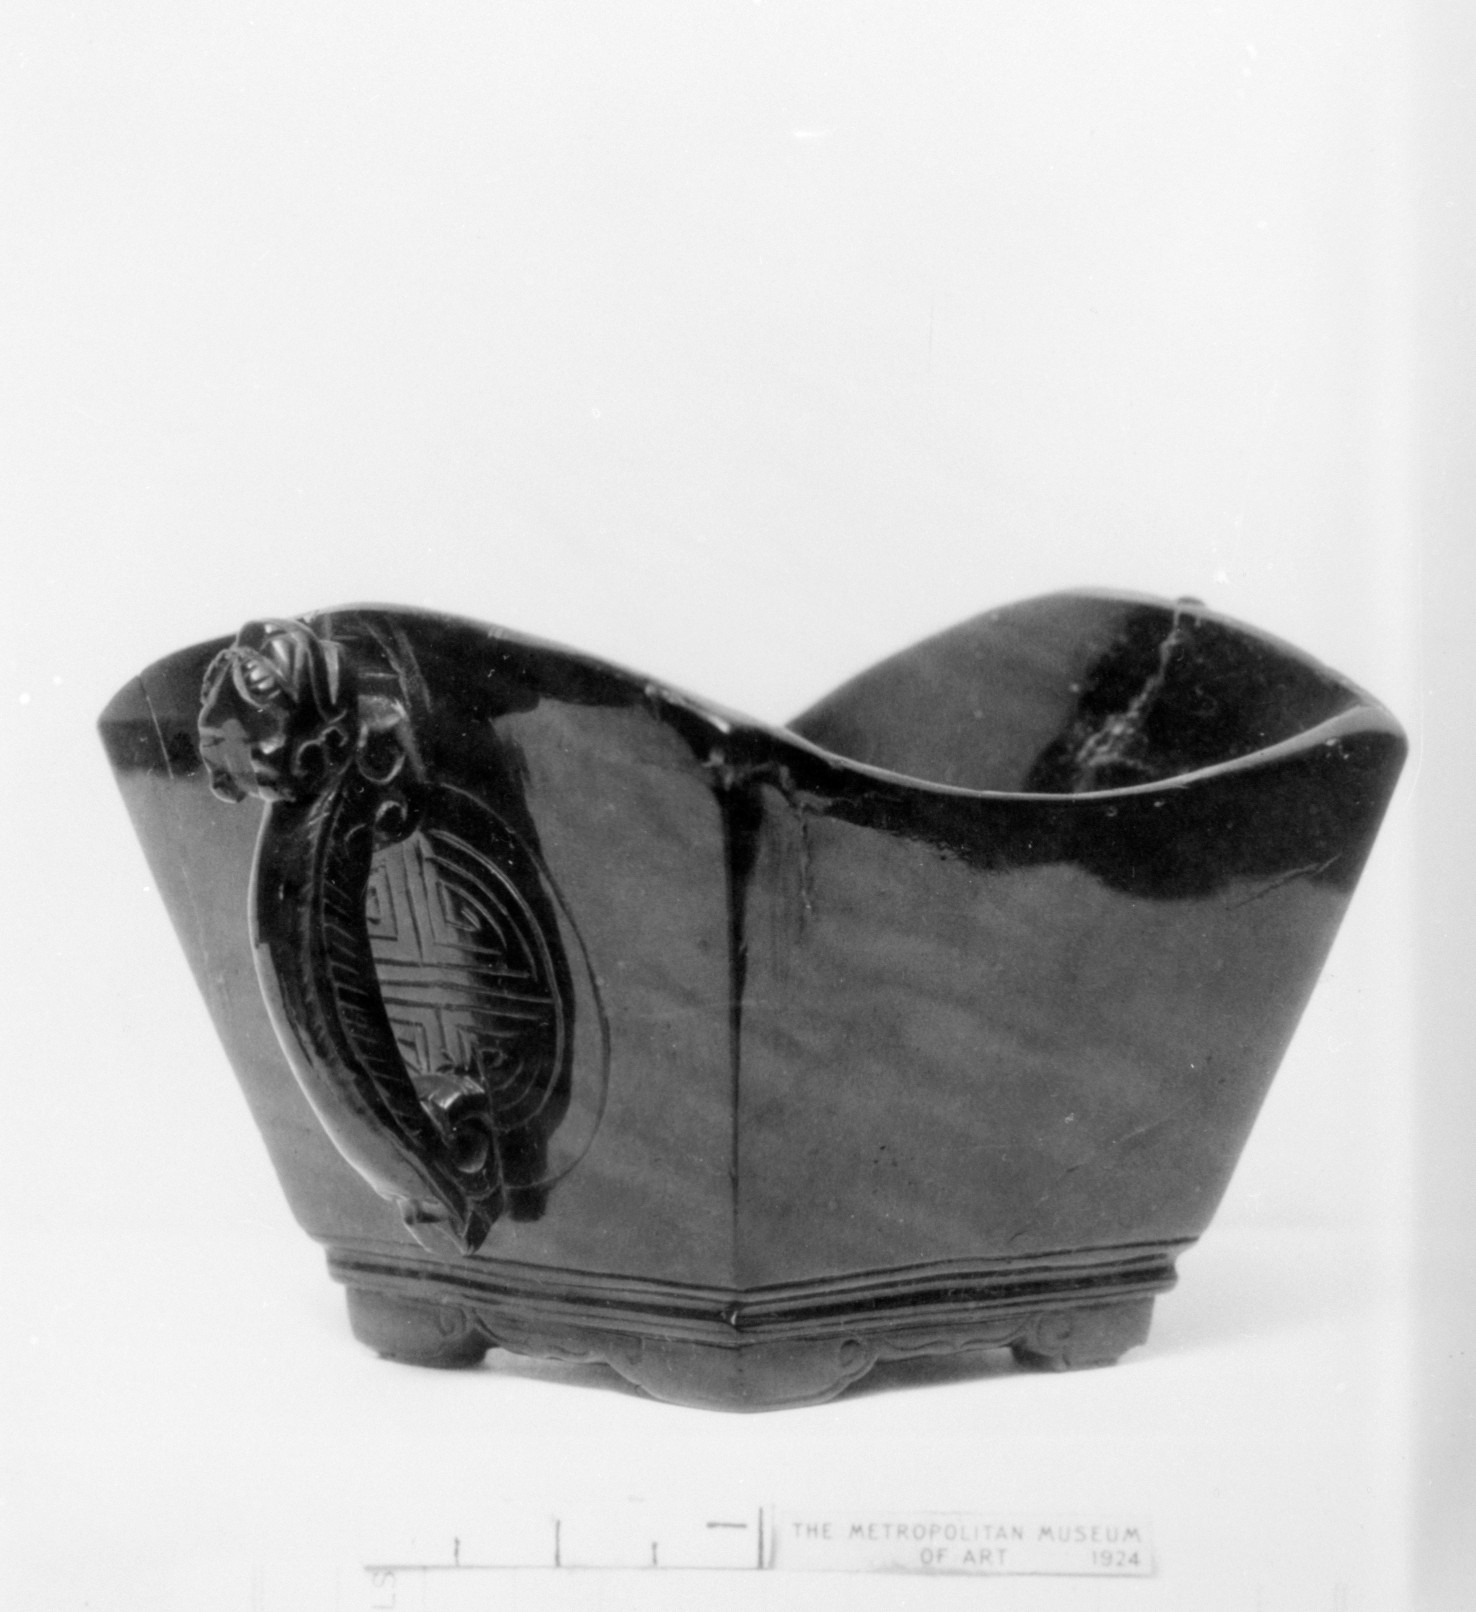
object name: cup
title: Square Cup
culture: chinese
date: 1662-1722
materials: amber